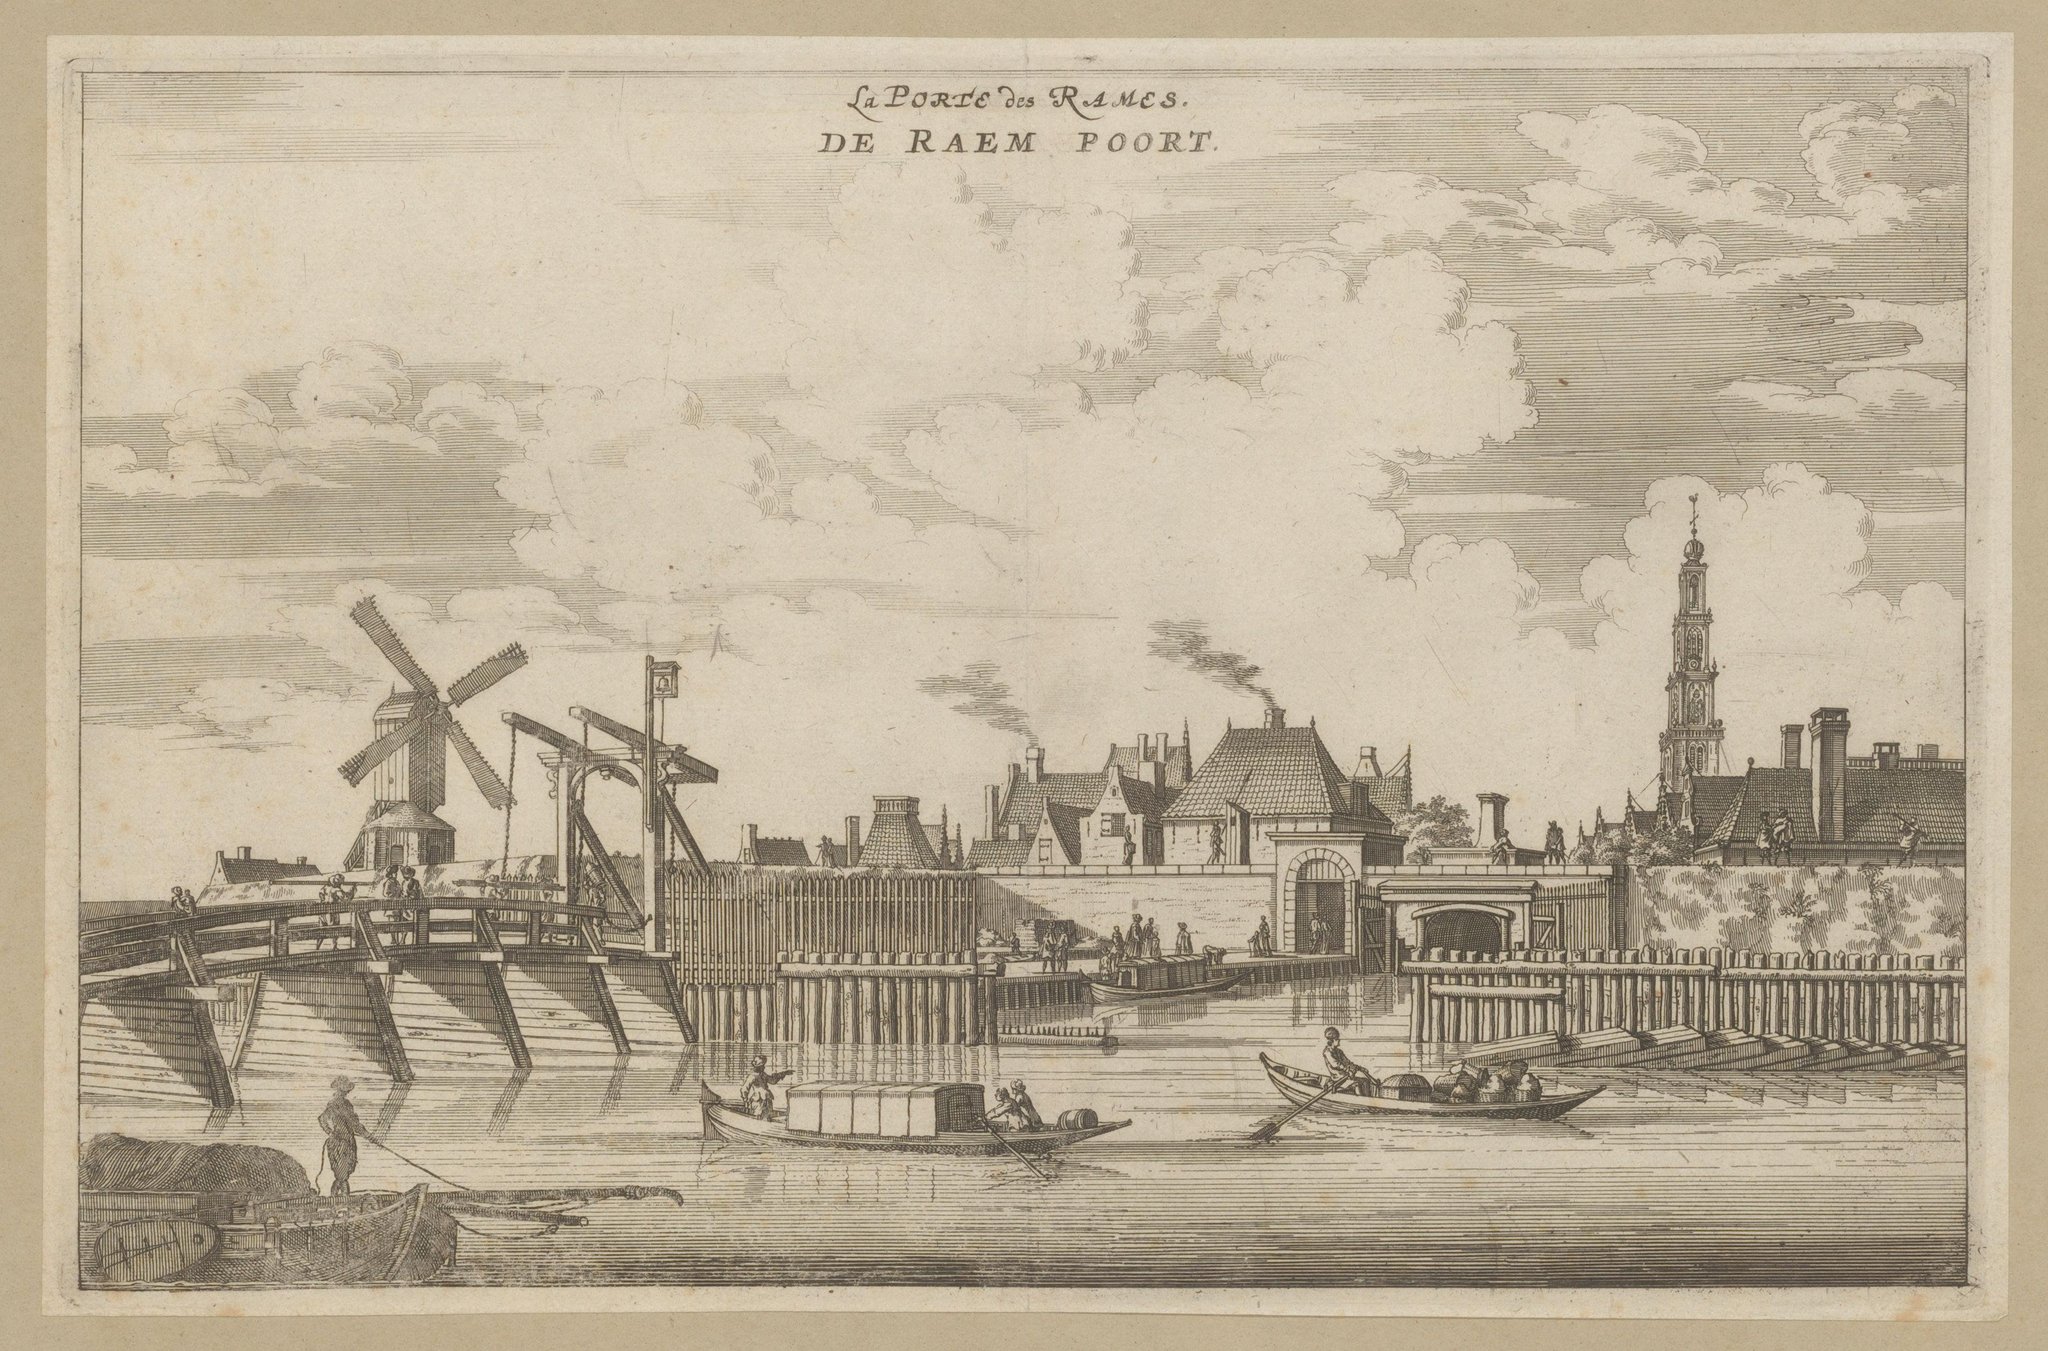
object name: print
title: De Raem Poort / La Porte des Rames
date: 1663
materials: paper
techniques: engraving, etching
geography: amsterdam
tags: rowing-boat, canoe, etc., windmill in landscape, parts of church exterior and annexes, bridge in city across river, canal, etc., city-gate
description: Prent uit: Dapper, Olfert. Historische beschryving der stadt Amsterdam (...). Amsterdam: Jacob van Meurs, 1663, tussen p. 452-453. Een identieke versie van de prent bestaat met een Frans opschrift boven het Nederlandse opschrift.